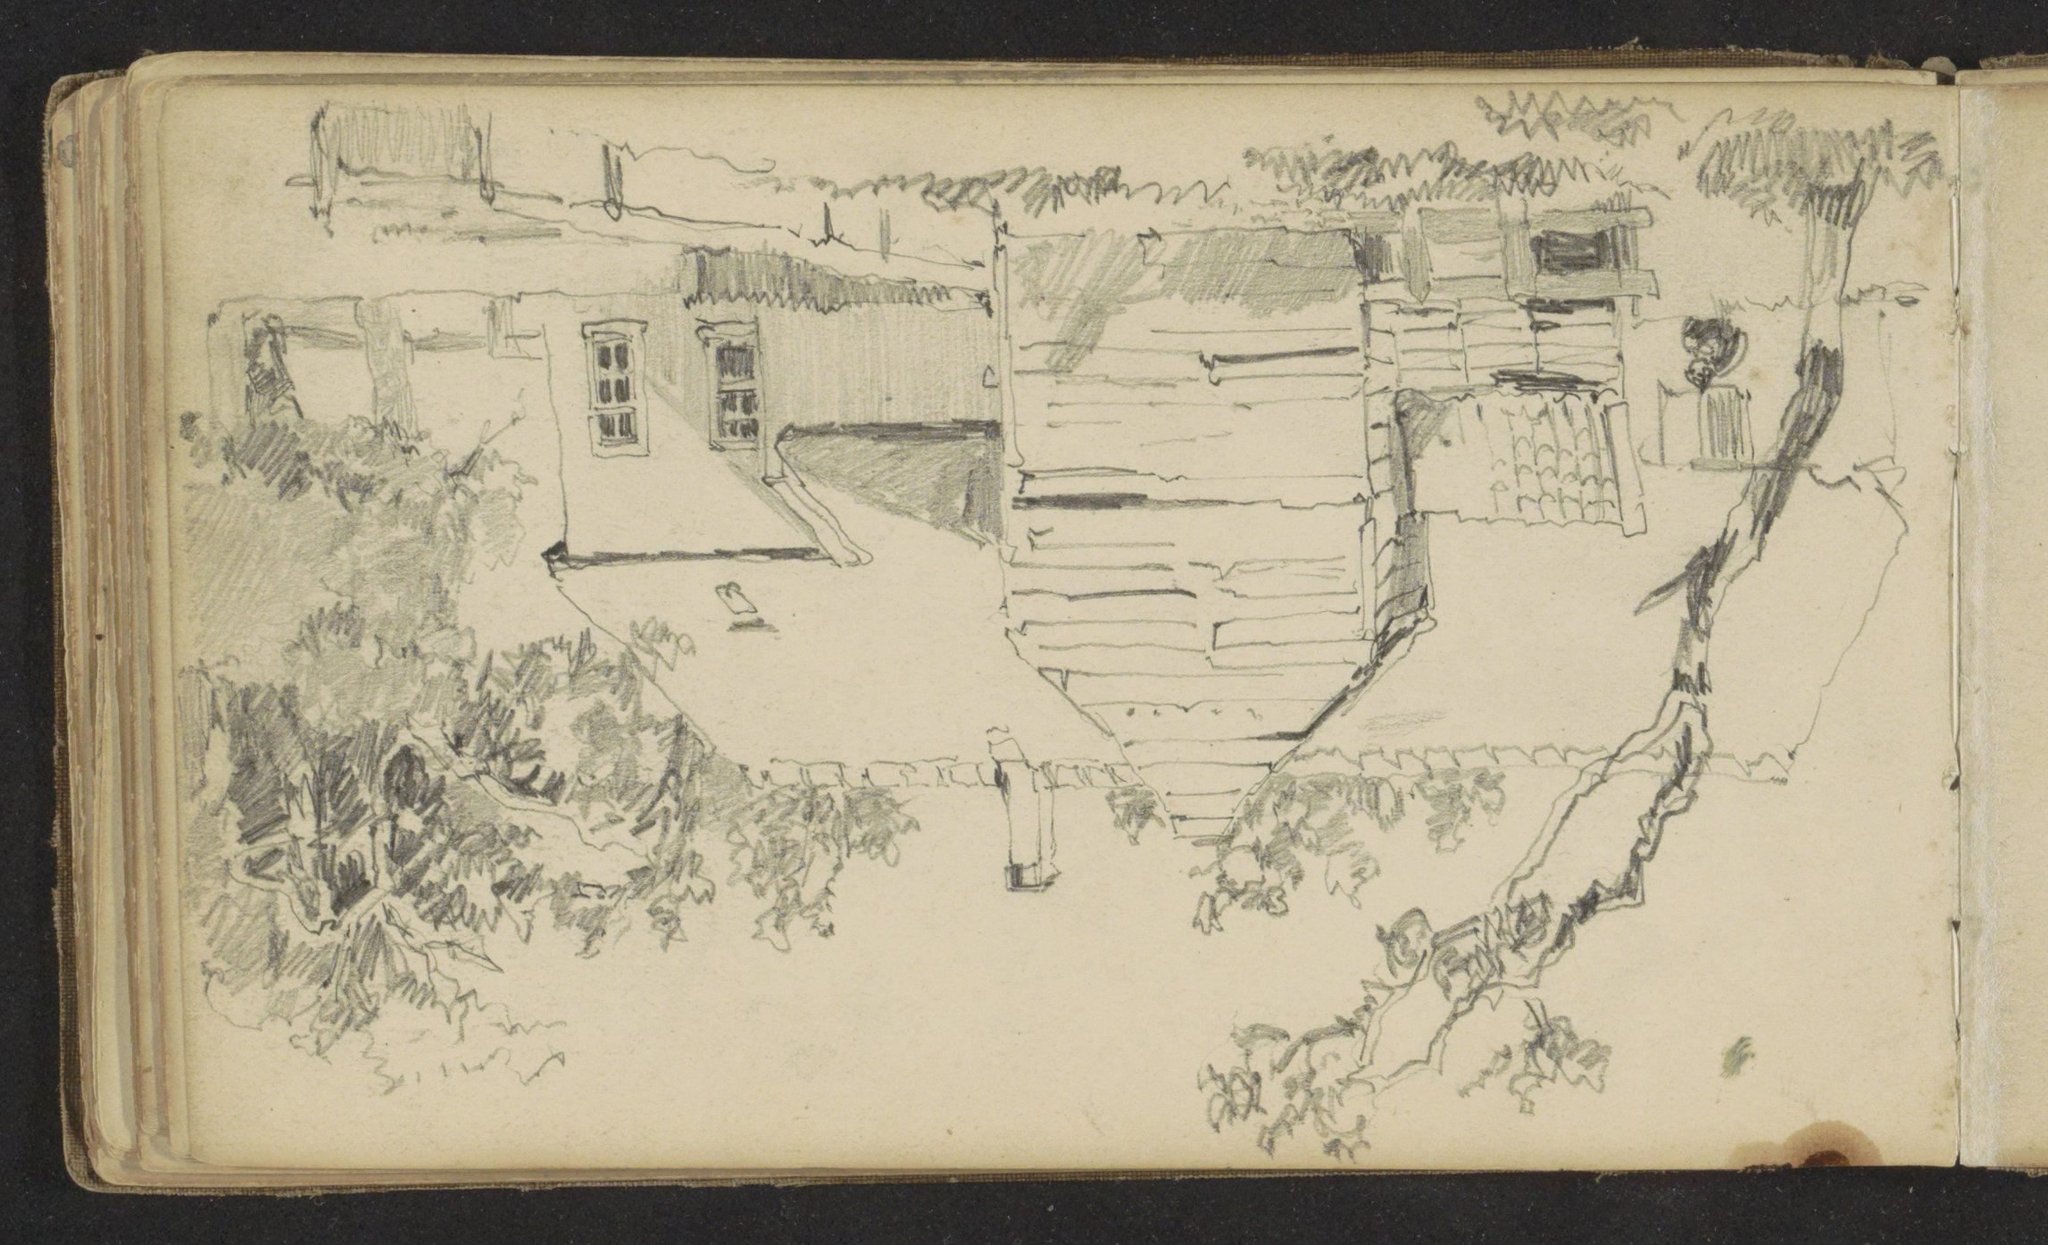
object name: sketchbook leaf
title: Boerderij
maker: johan hendrik weissenbruch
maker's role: draughtsman, painter, print maker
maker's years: 1824-1903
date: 1834-1903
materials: paper, pencil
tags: farm (building)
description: Blad 37 verso uit een schetsboek met 43 bladen.